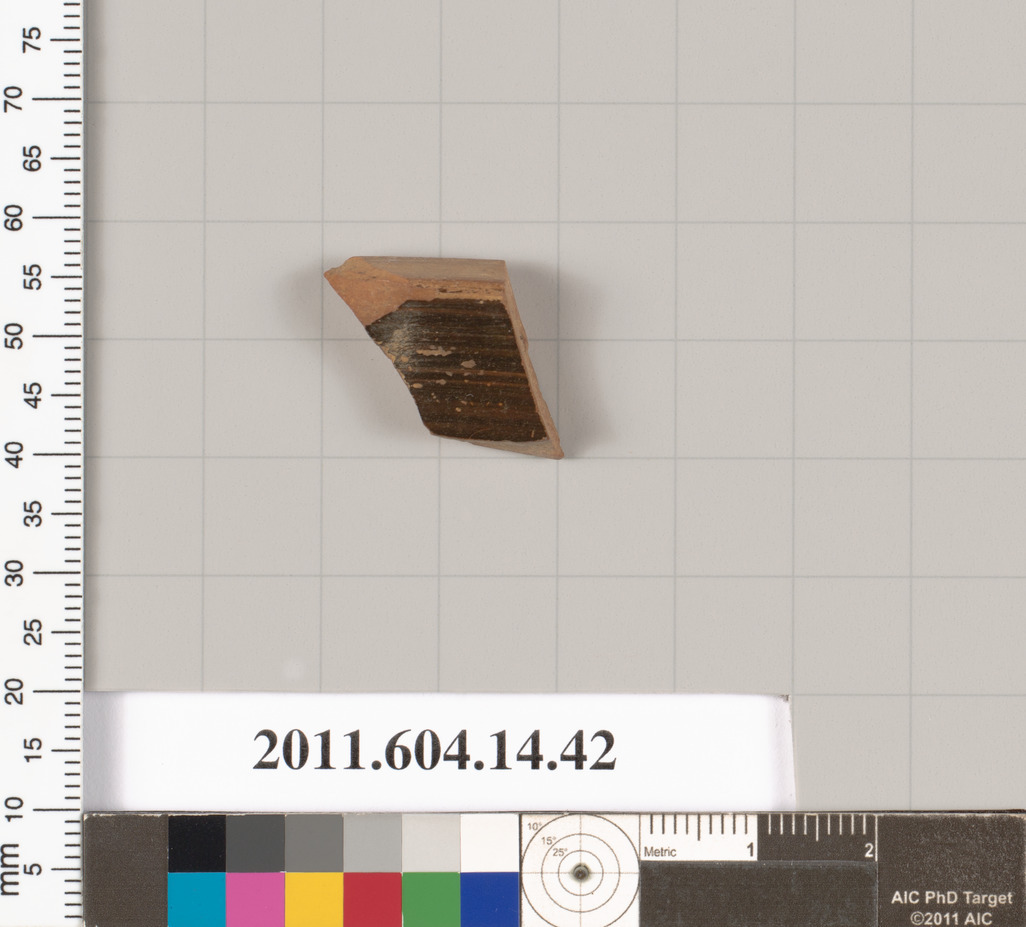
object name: undetermined open shape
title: Terracotta fragment of an open shape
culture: unknown fabric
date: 600-401 BCE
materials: terracotta